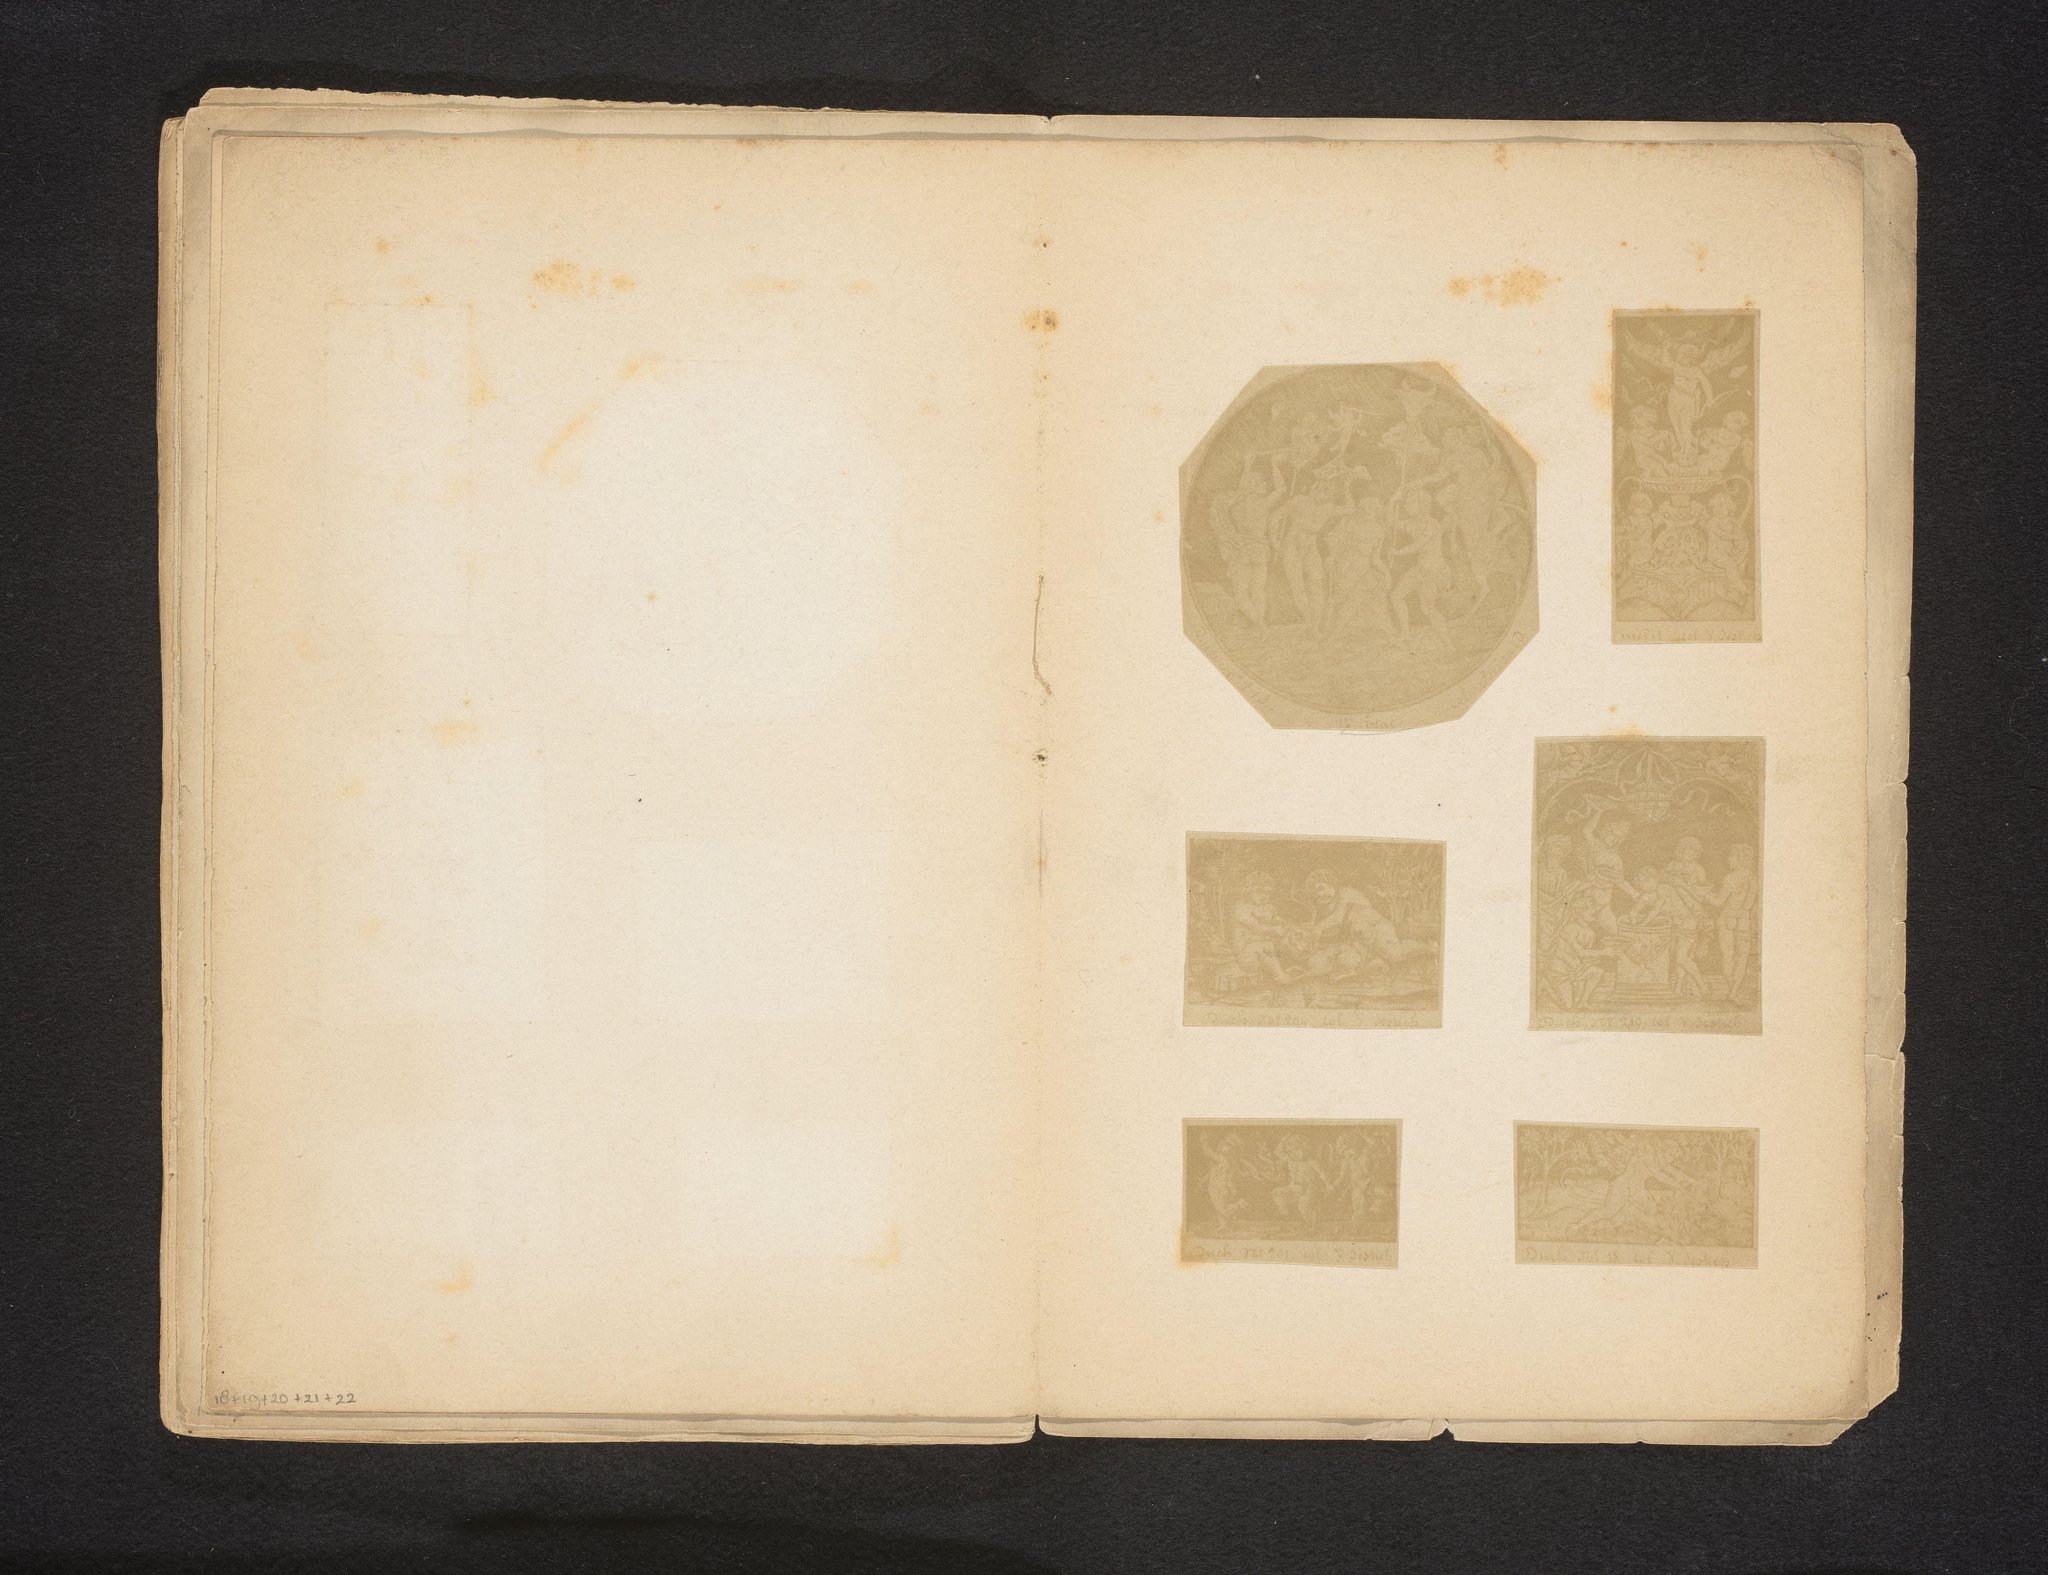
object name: page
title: Fotoreproductie van een prent van de triomf van de liefde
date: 1852-1857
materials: photographic support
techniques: salted paper print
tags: vase ~ ornament, cupids: 'amores', 'amoretti', 'putti'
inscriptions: inscription: ‘medit col. V. Sestich’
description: Foto op blad met zes foto's op negende ongenummerde pagina na pagina 60.